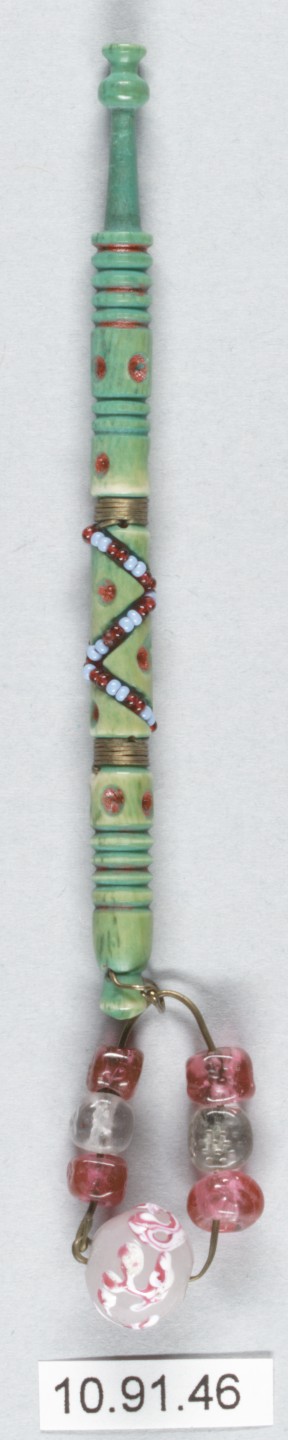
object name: bobbin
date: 1801-1900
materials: bone, metal